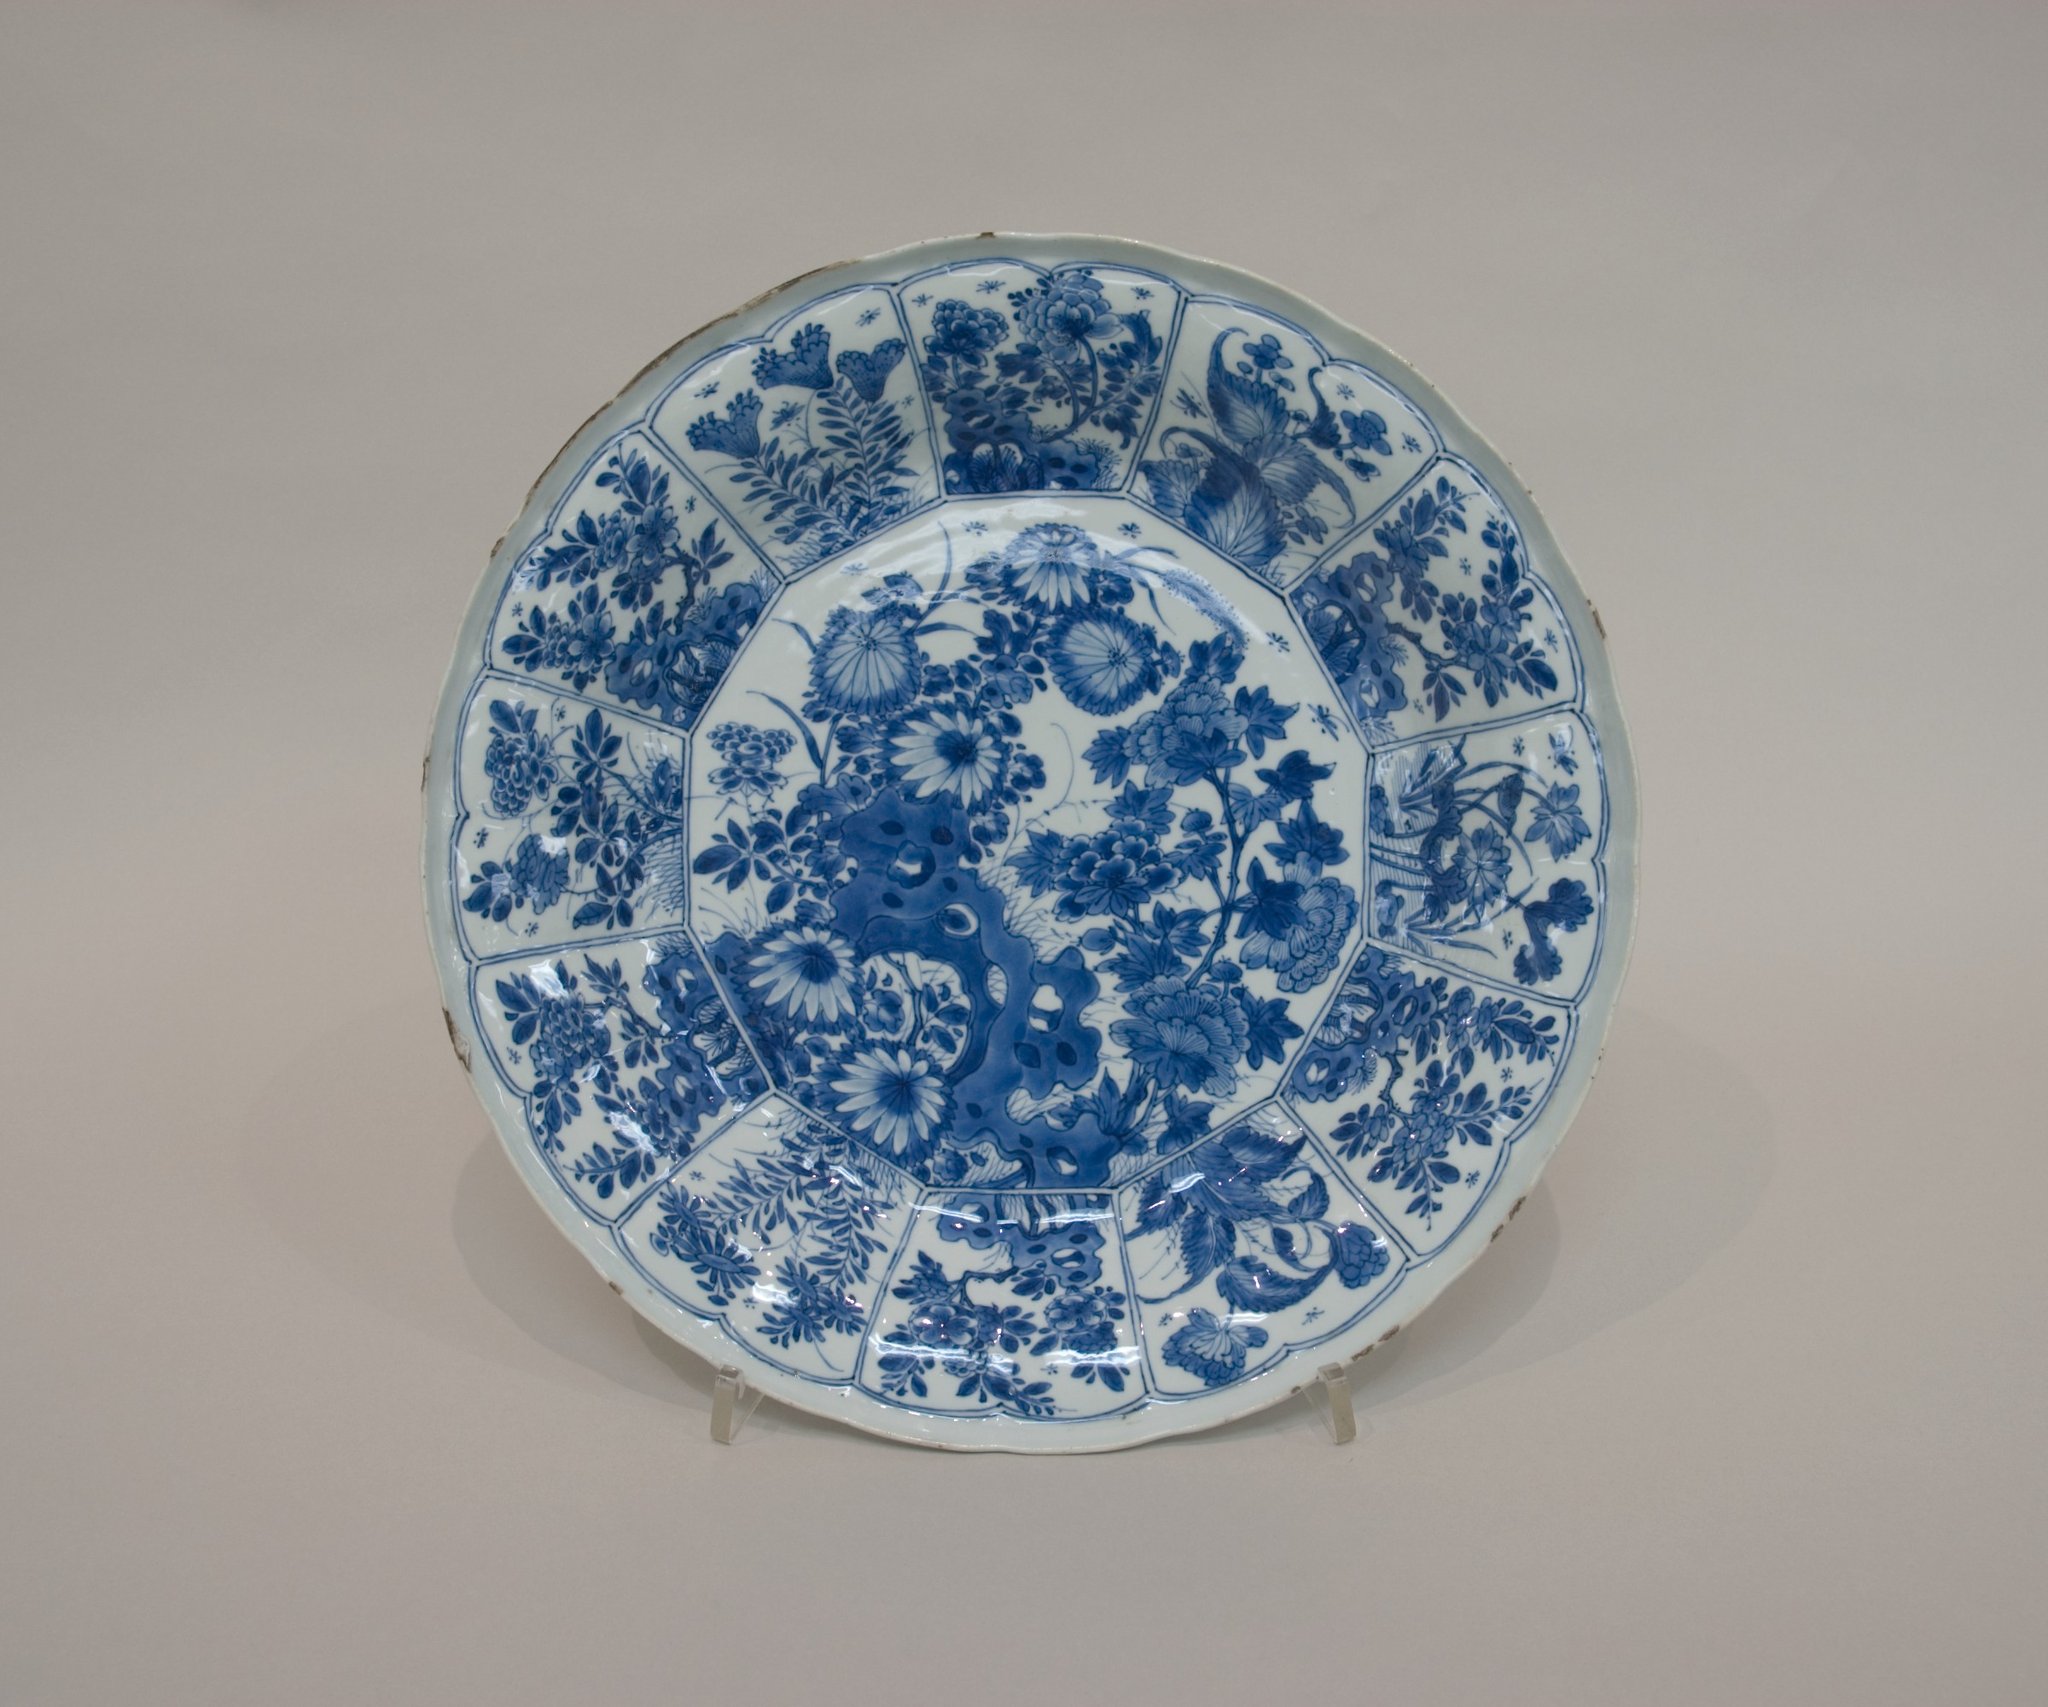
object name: dish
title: Dish with flowers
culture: chinese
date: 1667-1733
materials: cobalt, porcelain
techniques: painting, underglaze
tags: flowers,leaves